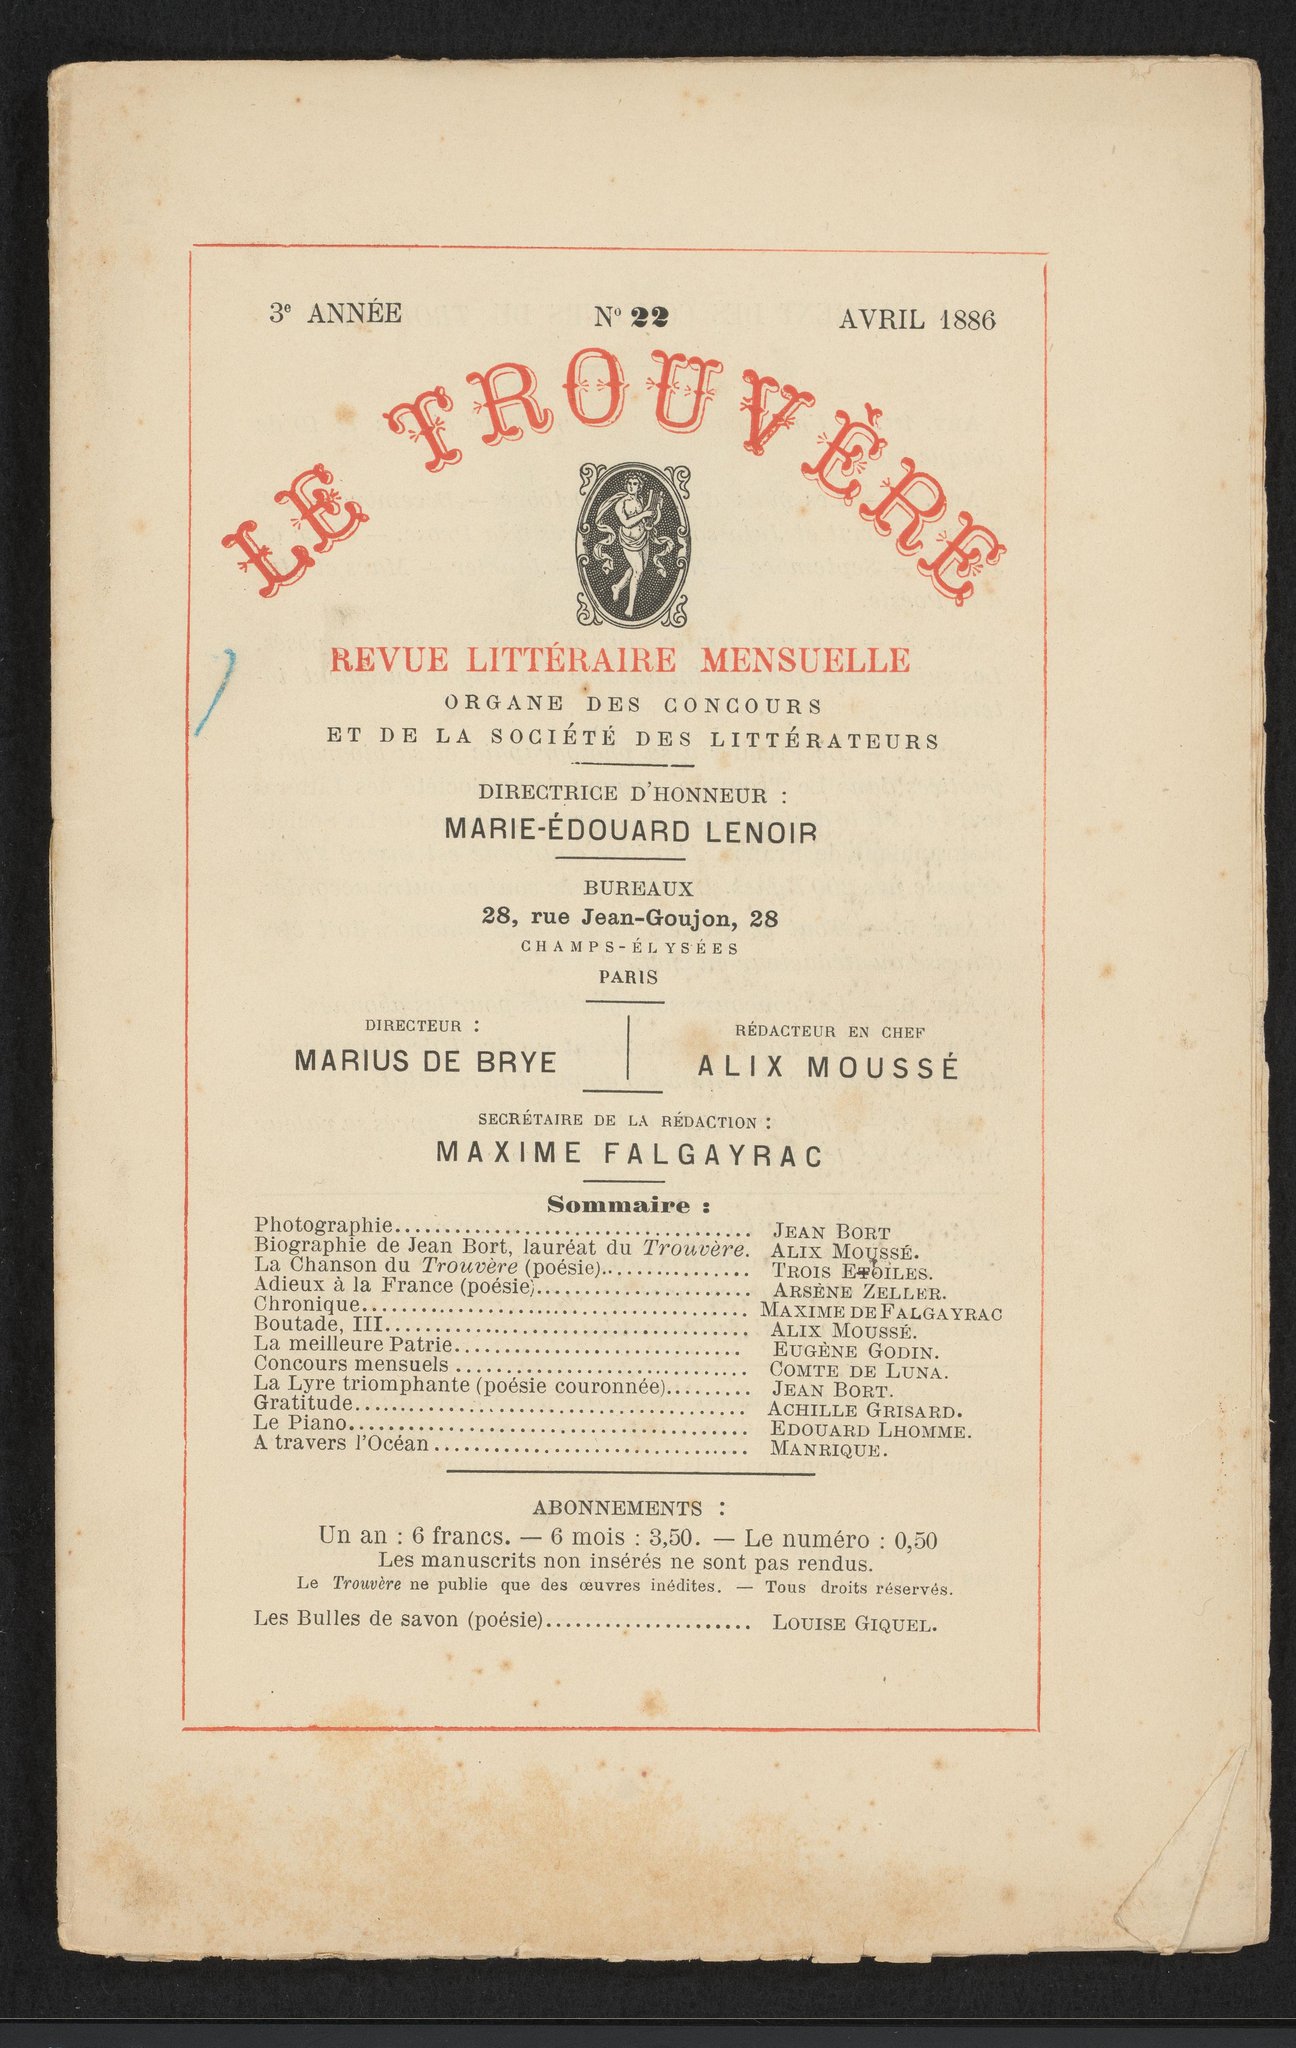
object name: book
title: Le trouvère No 22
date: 1804-1886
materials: paper, photographic support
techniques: albumen print, printing, engraving